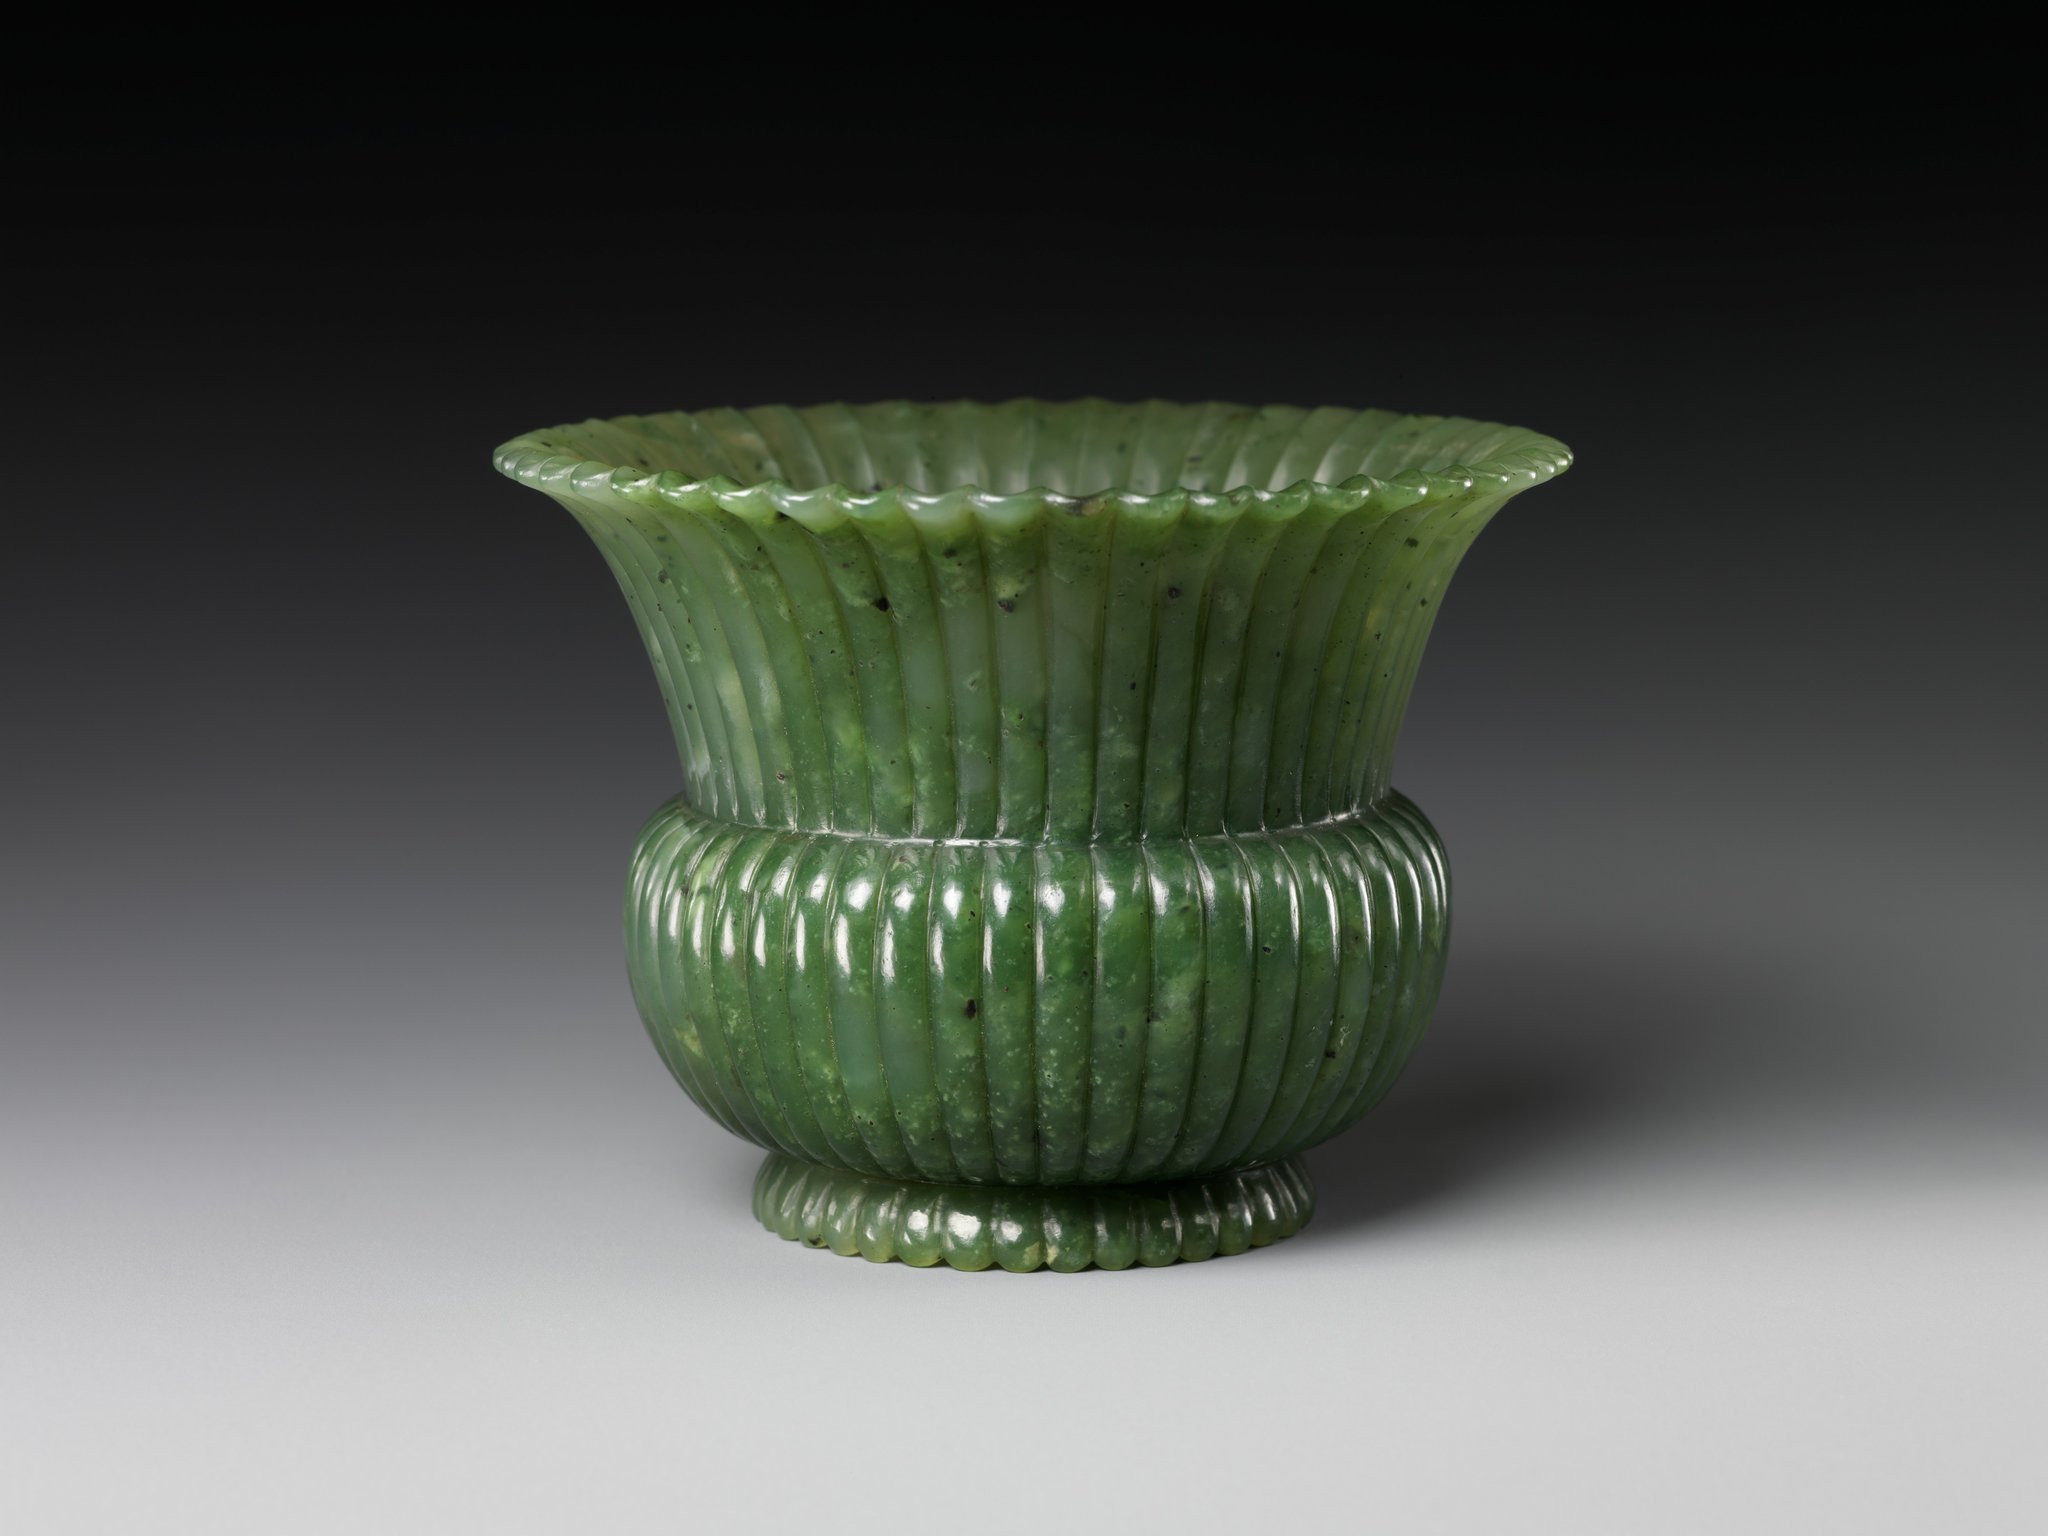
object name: vessel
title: Vessel in the shape of a chrysanthemum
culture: chinese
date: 1736-1795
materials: jade